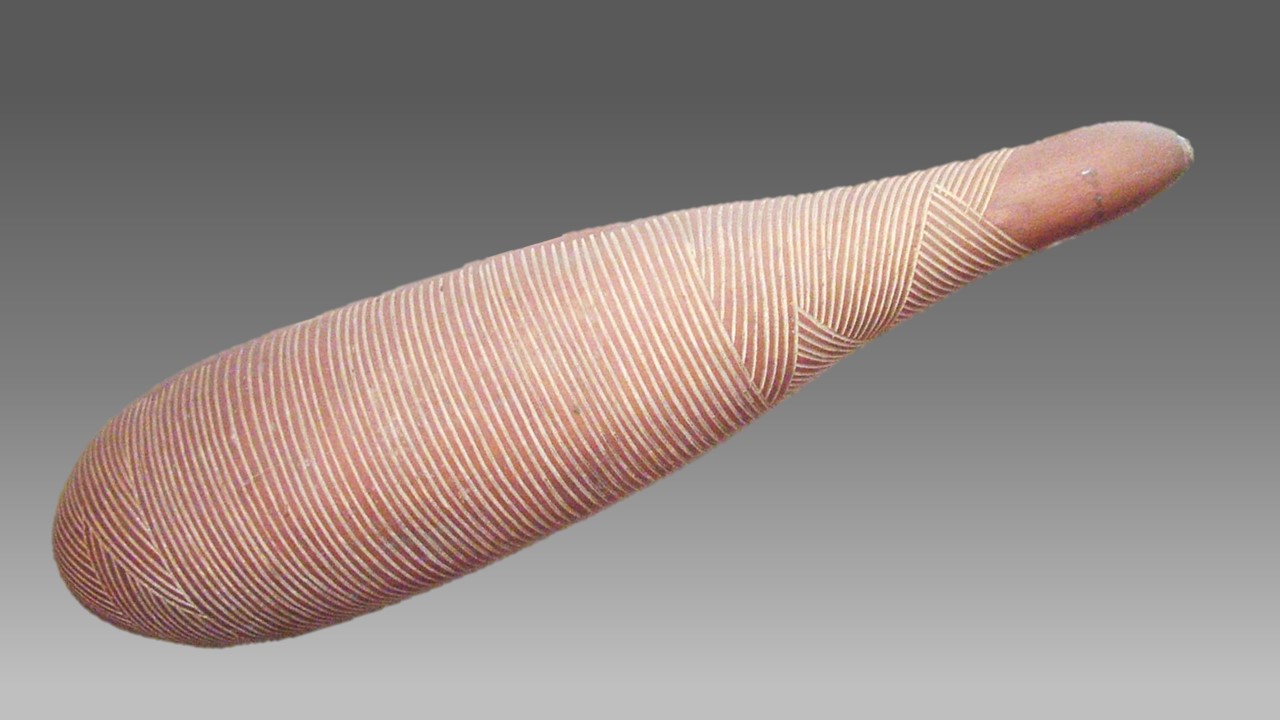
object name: güiro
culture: cuban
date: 1867-1900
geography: cuba